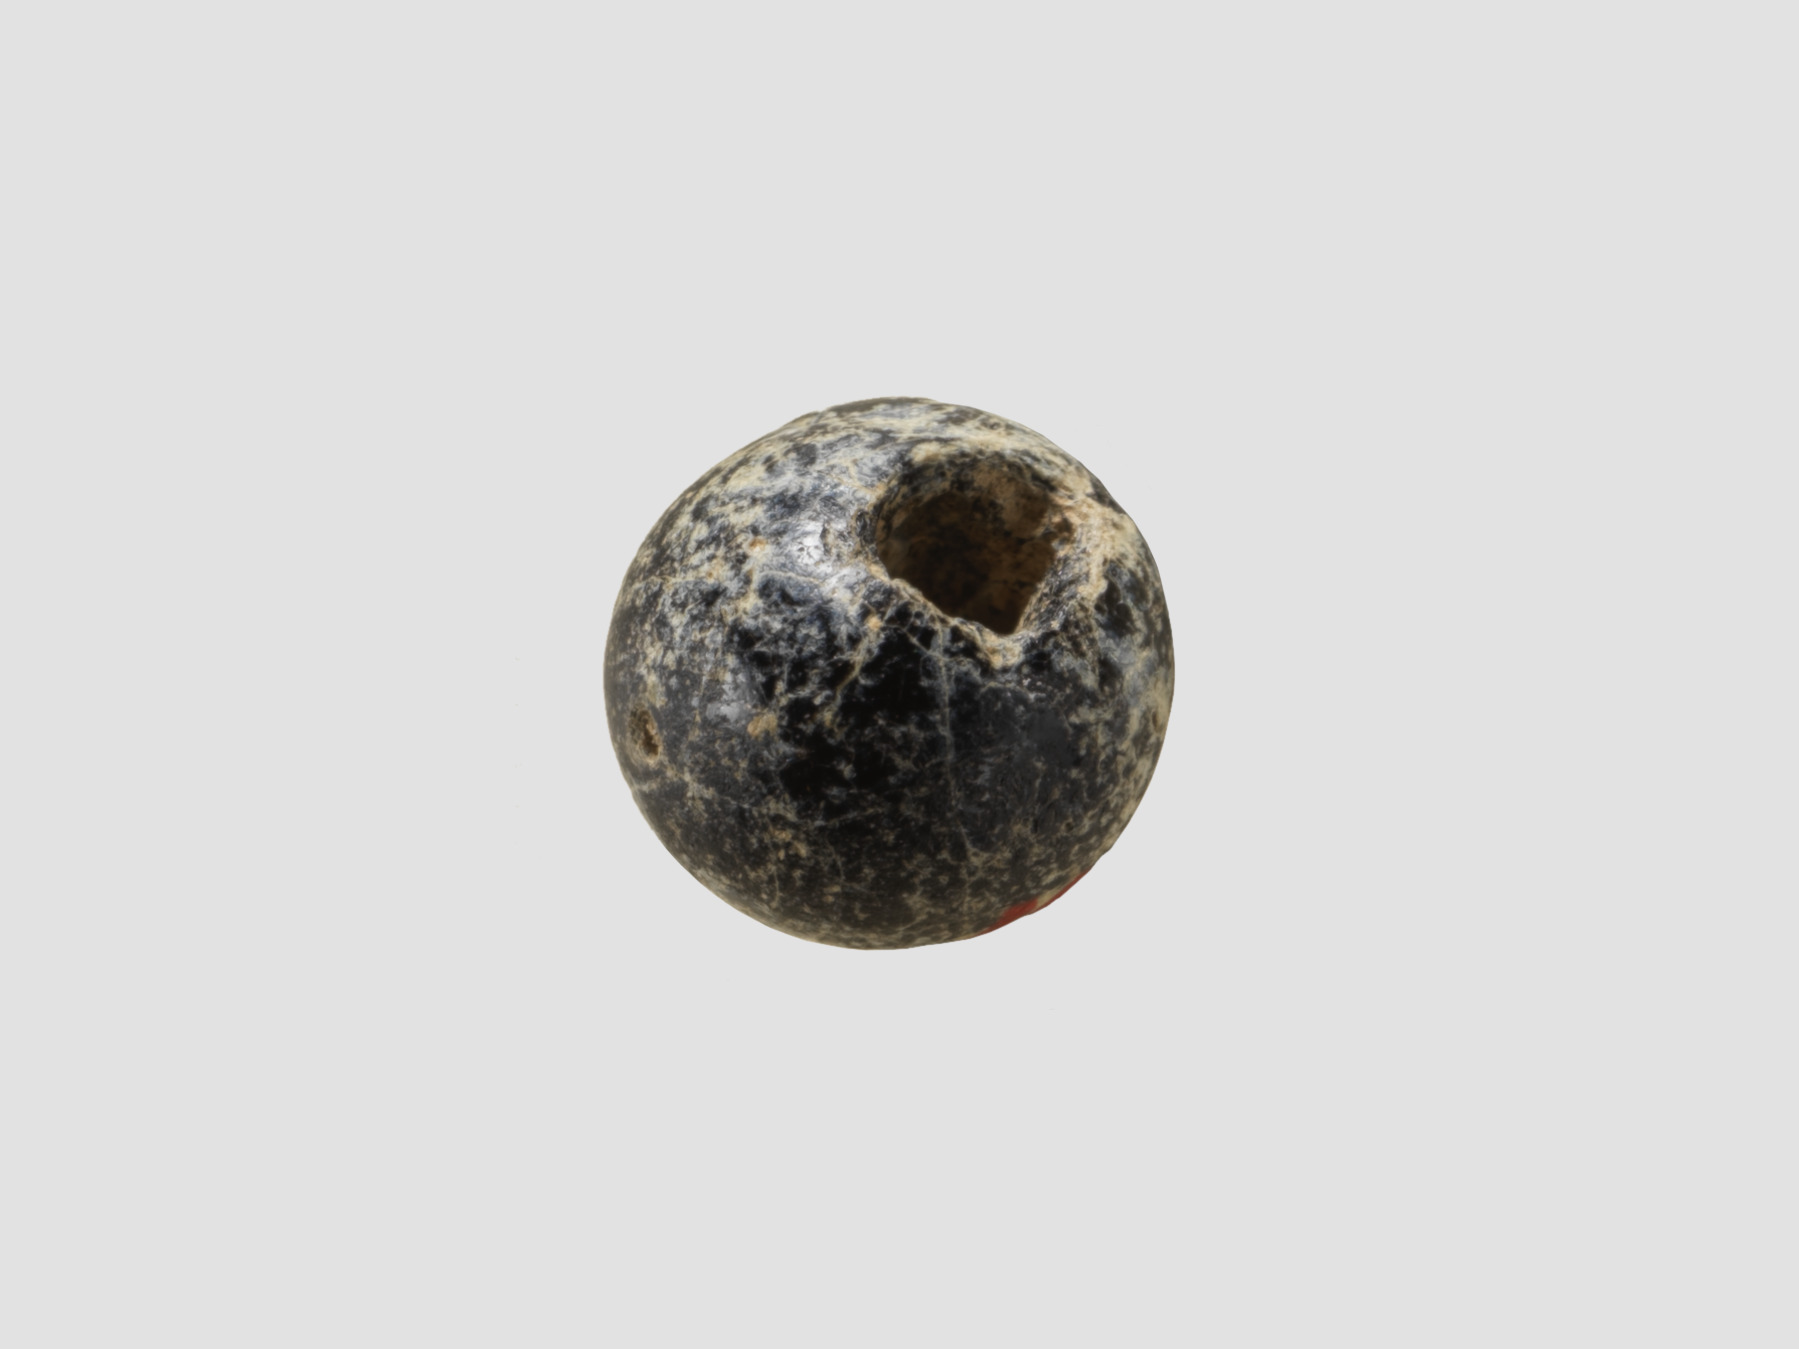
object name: bead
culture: parthian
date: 1-100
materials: glass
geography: iran